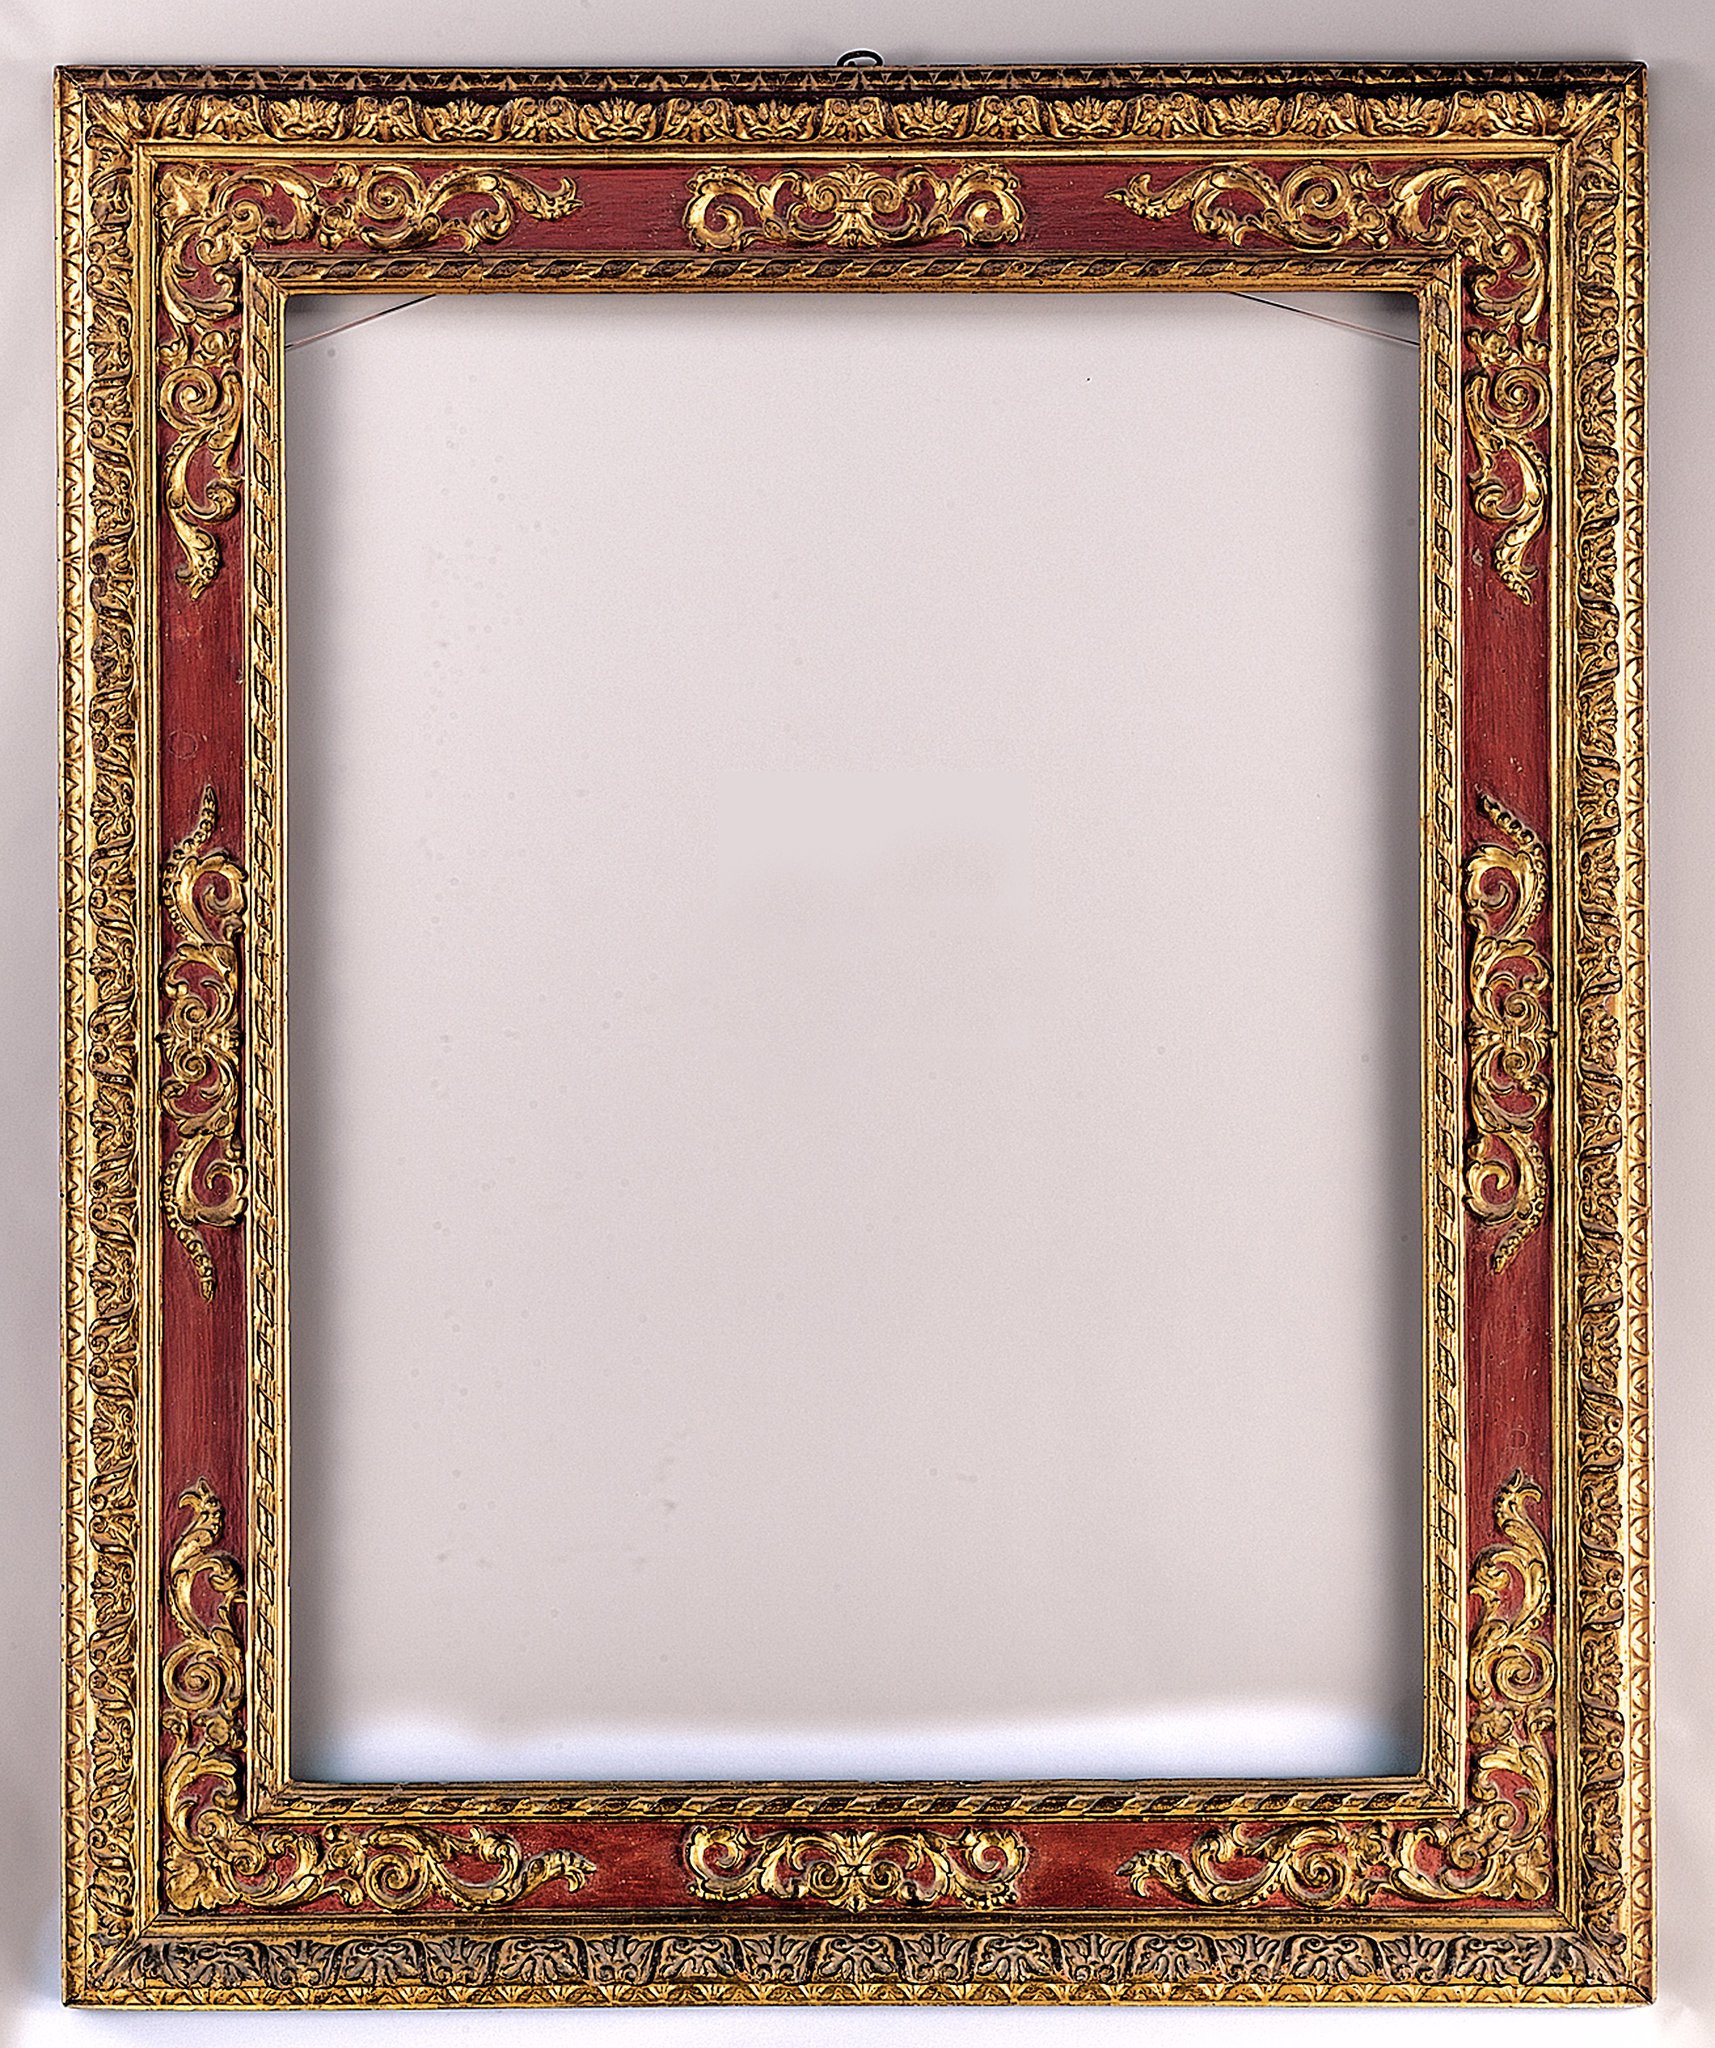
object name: frame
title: Cassetta frame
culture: italian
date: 1601-1633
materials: wood